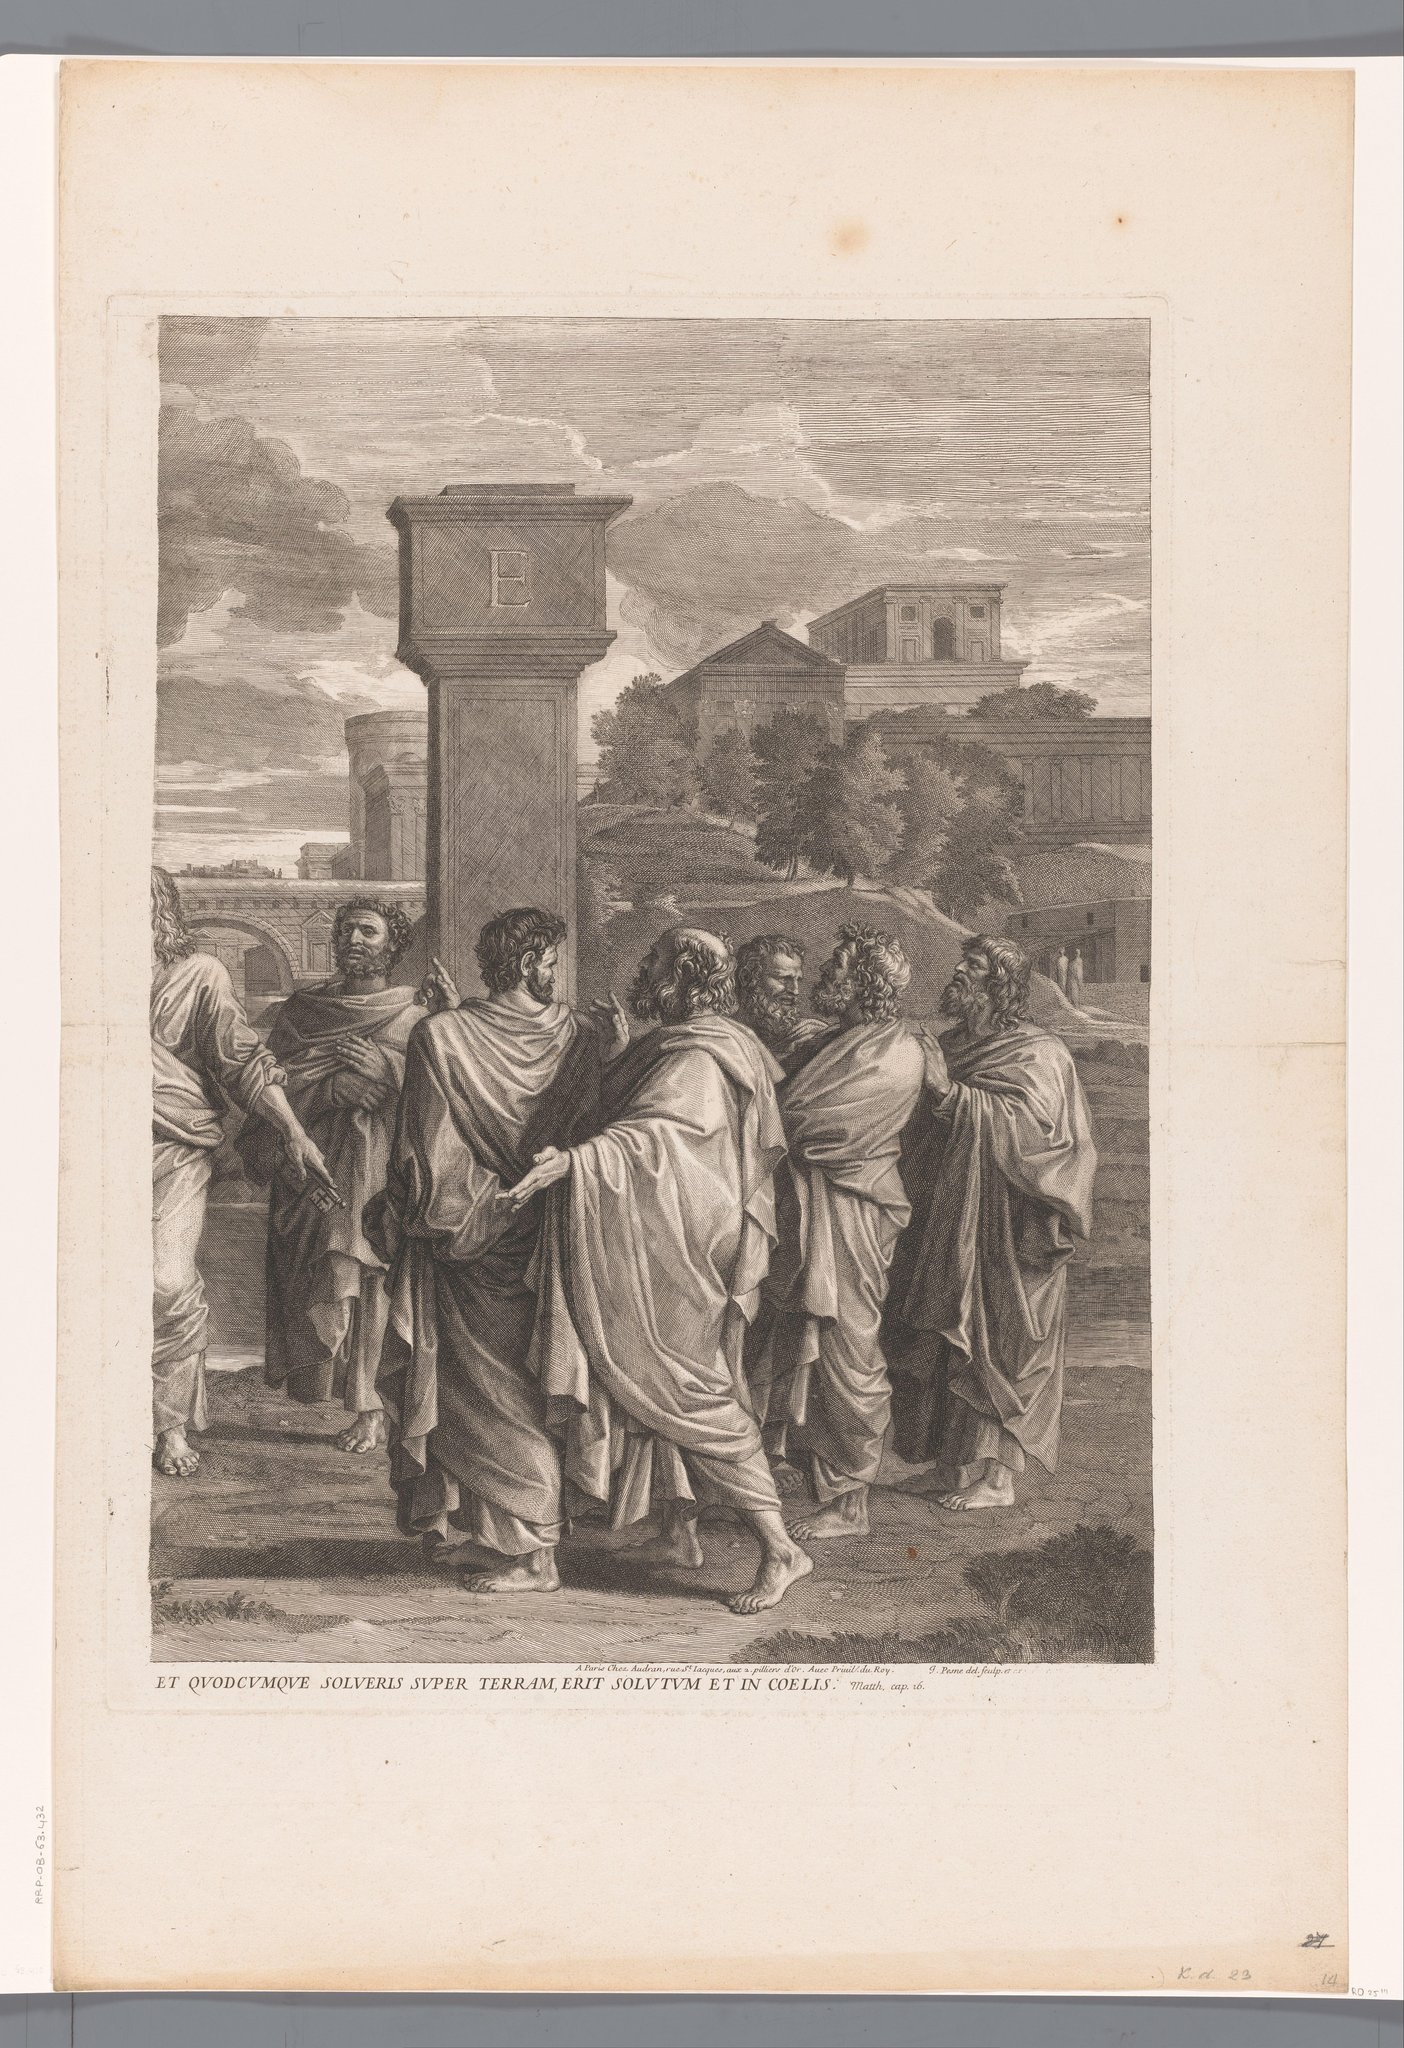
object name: print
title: Et quodcumque solueris (...) in coelis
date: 1680-1694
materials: paper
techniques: etching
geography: france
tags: christ gives the keys of heaven to peter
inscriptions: collector's mark: Lugt 240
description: Prent maakt deel uit van een ongenummerde serie van zeven prenten.